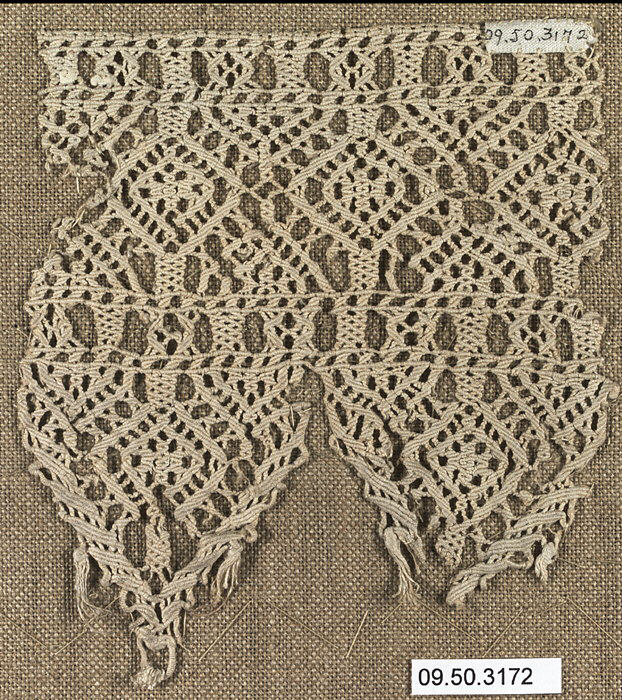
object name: fragment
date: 1601-1800